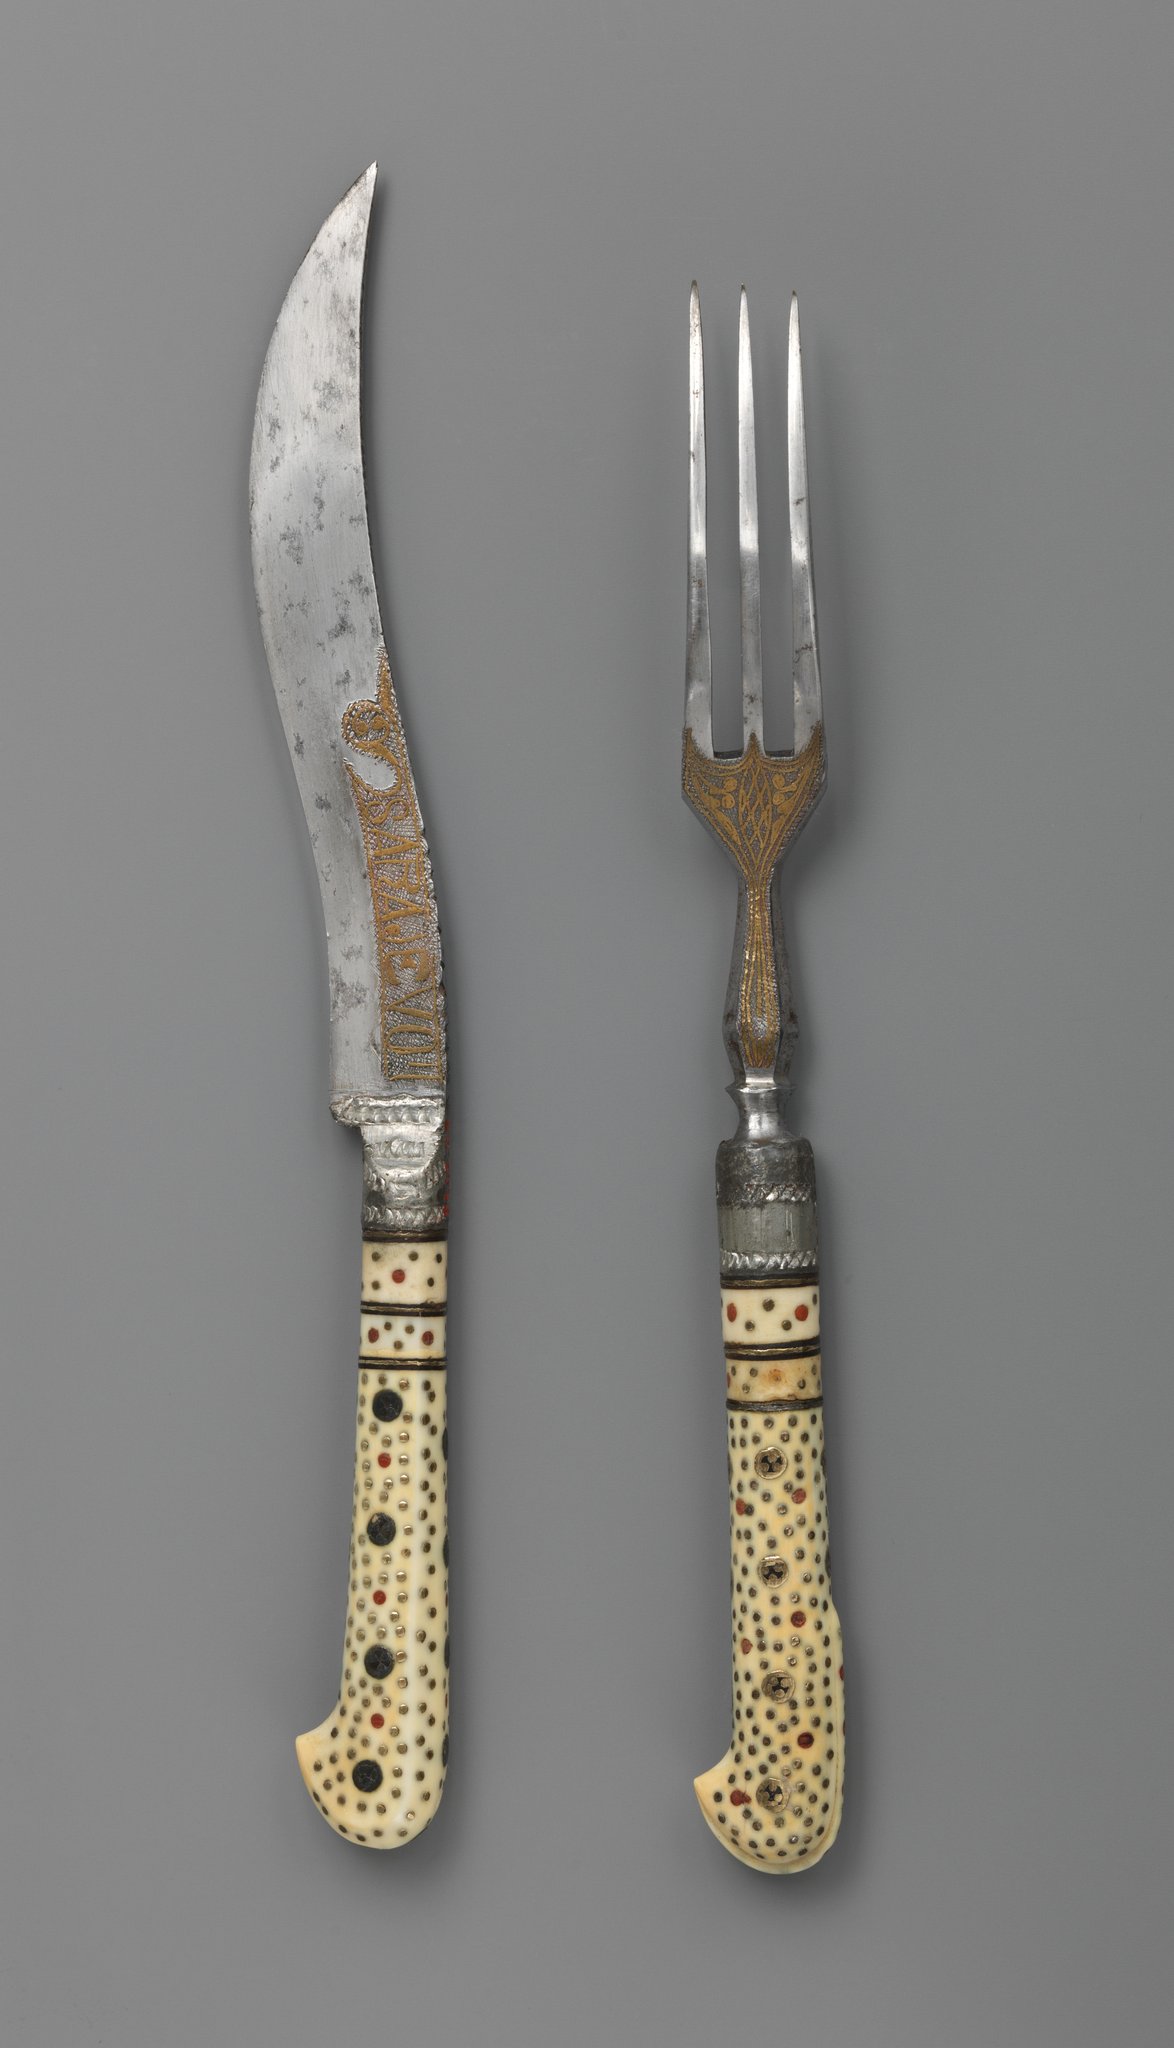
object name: table knife and fork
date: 1801-1900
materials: bone, steel